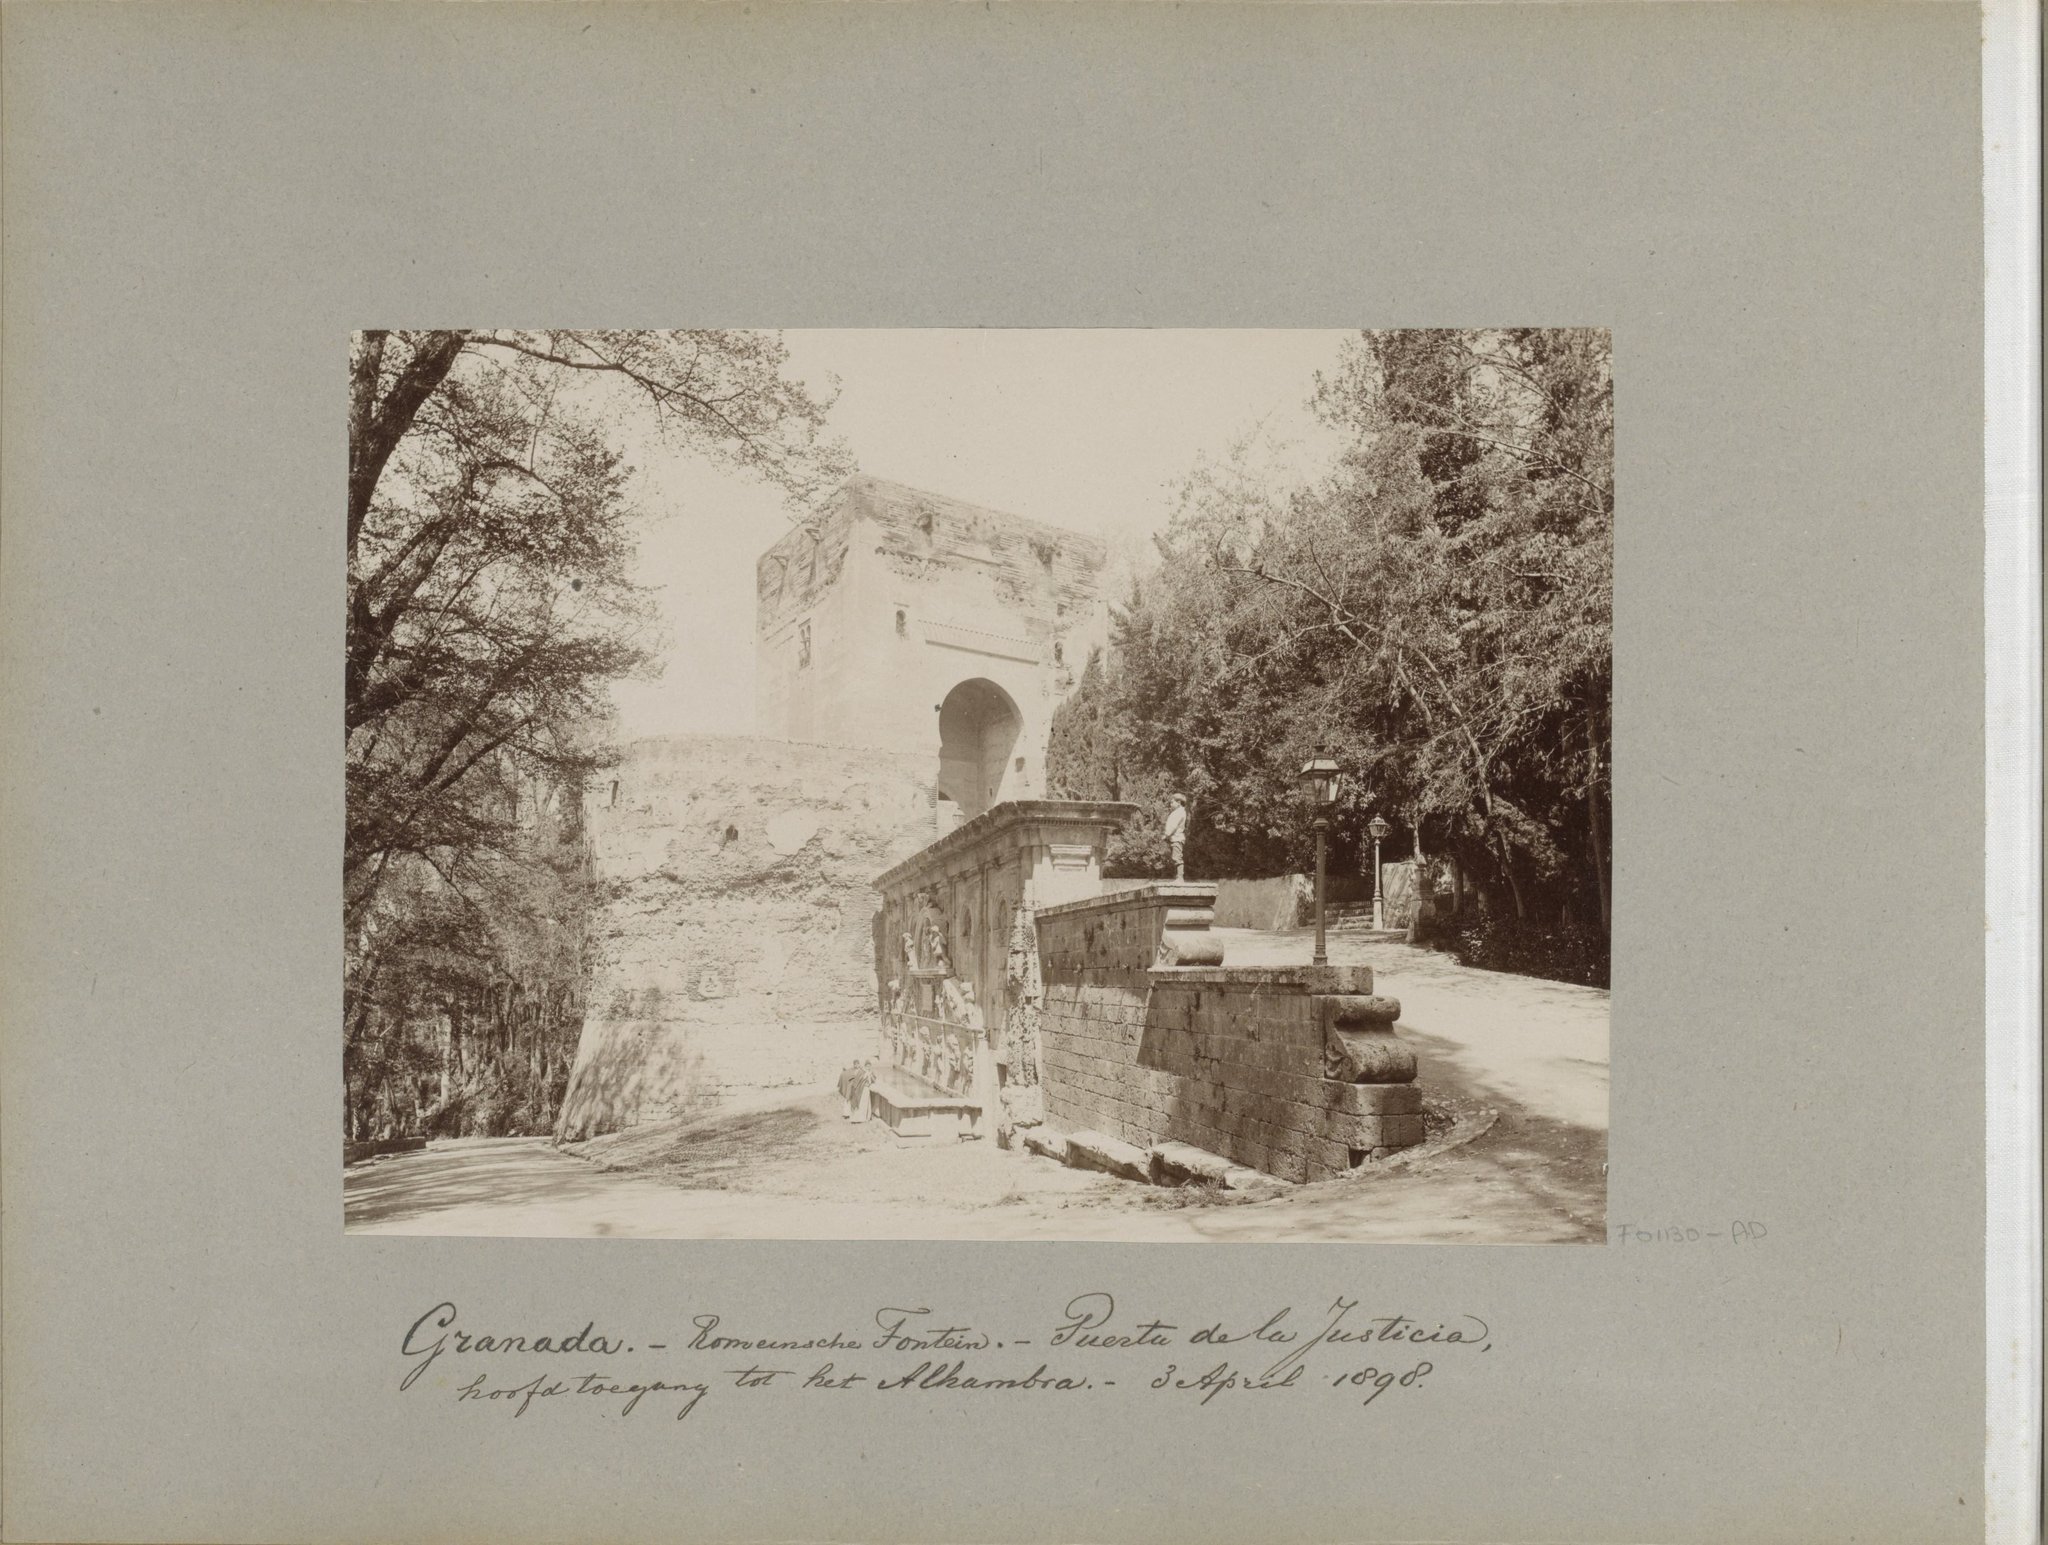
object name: album leaf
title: Romeinse fontein en de Puerta de la Justicia bij een ingang van het Alhambra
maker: Anonymous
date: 1880-1898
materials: paper, photographic support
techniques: albumen print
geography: granada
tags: gate ~ fortified city, ornamental fountain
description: Onderdeel van Reisalbum met foto's van bezienswaardigheden in Frankrijk, Spanje, Italië, Duitsland, Zwitserland en Oostenrijk.